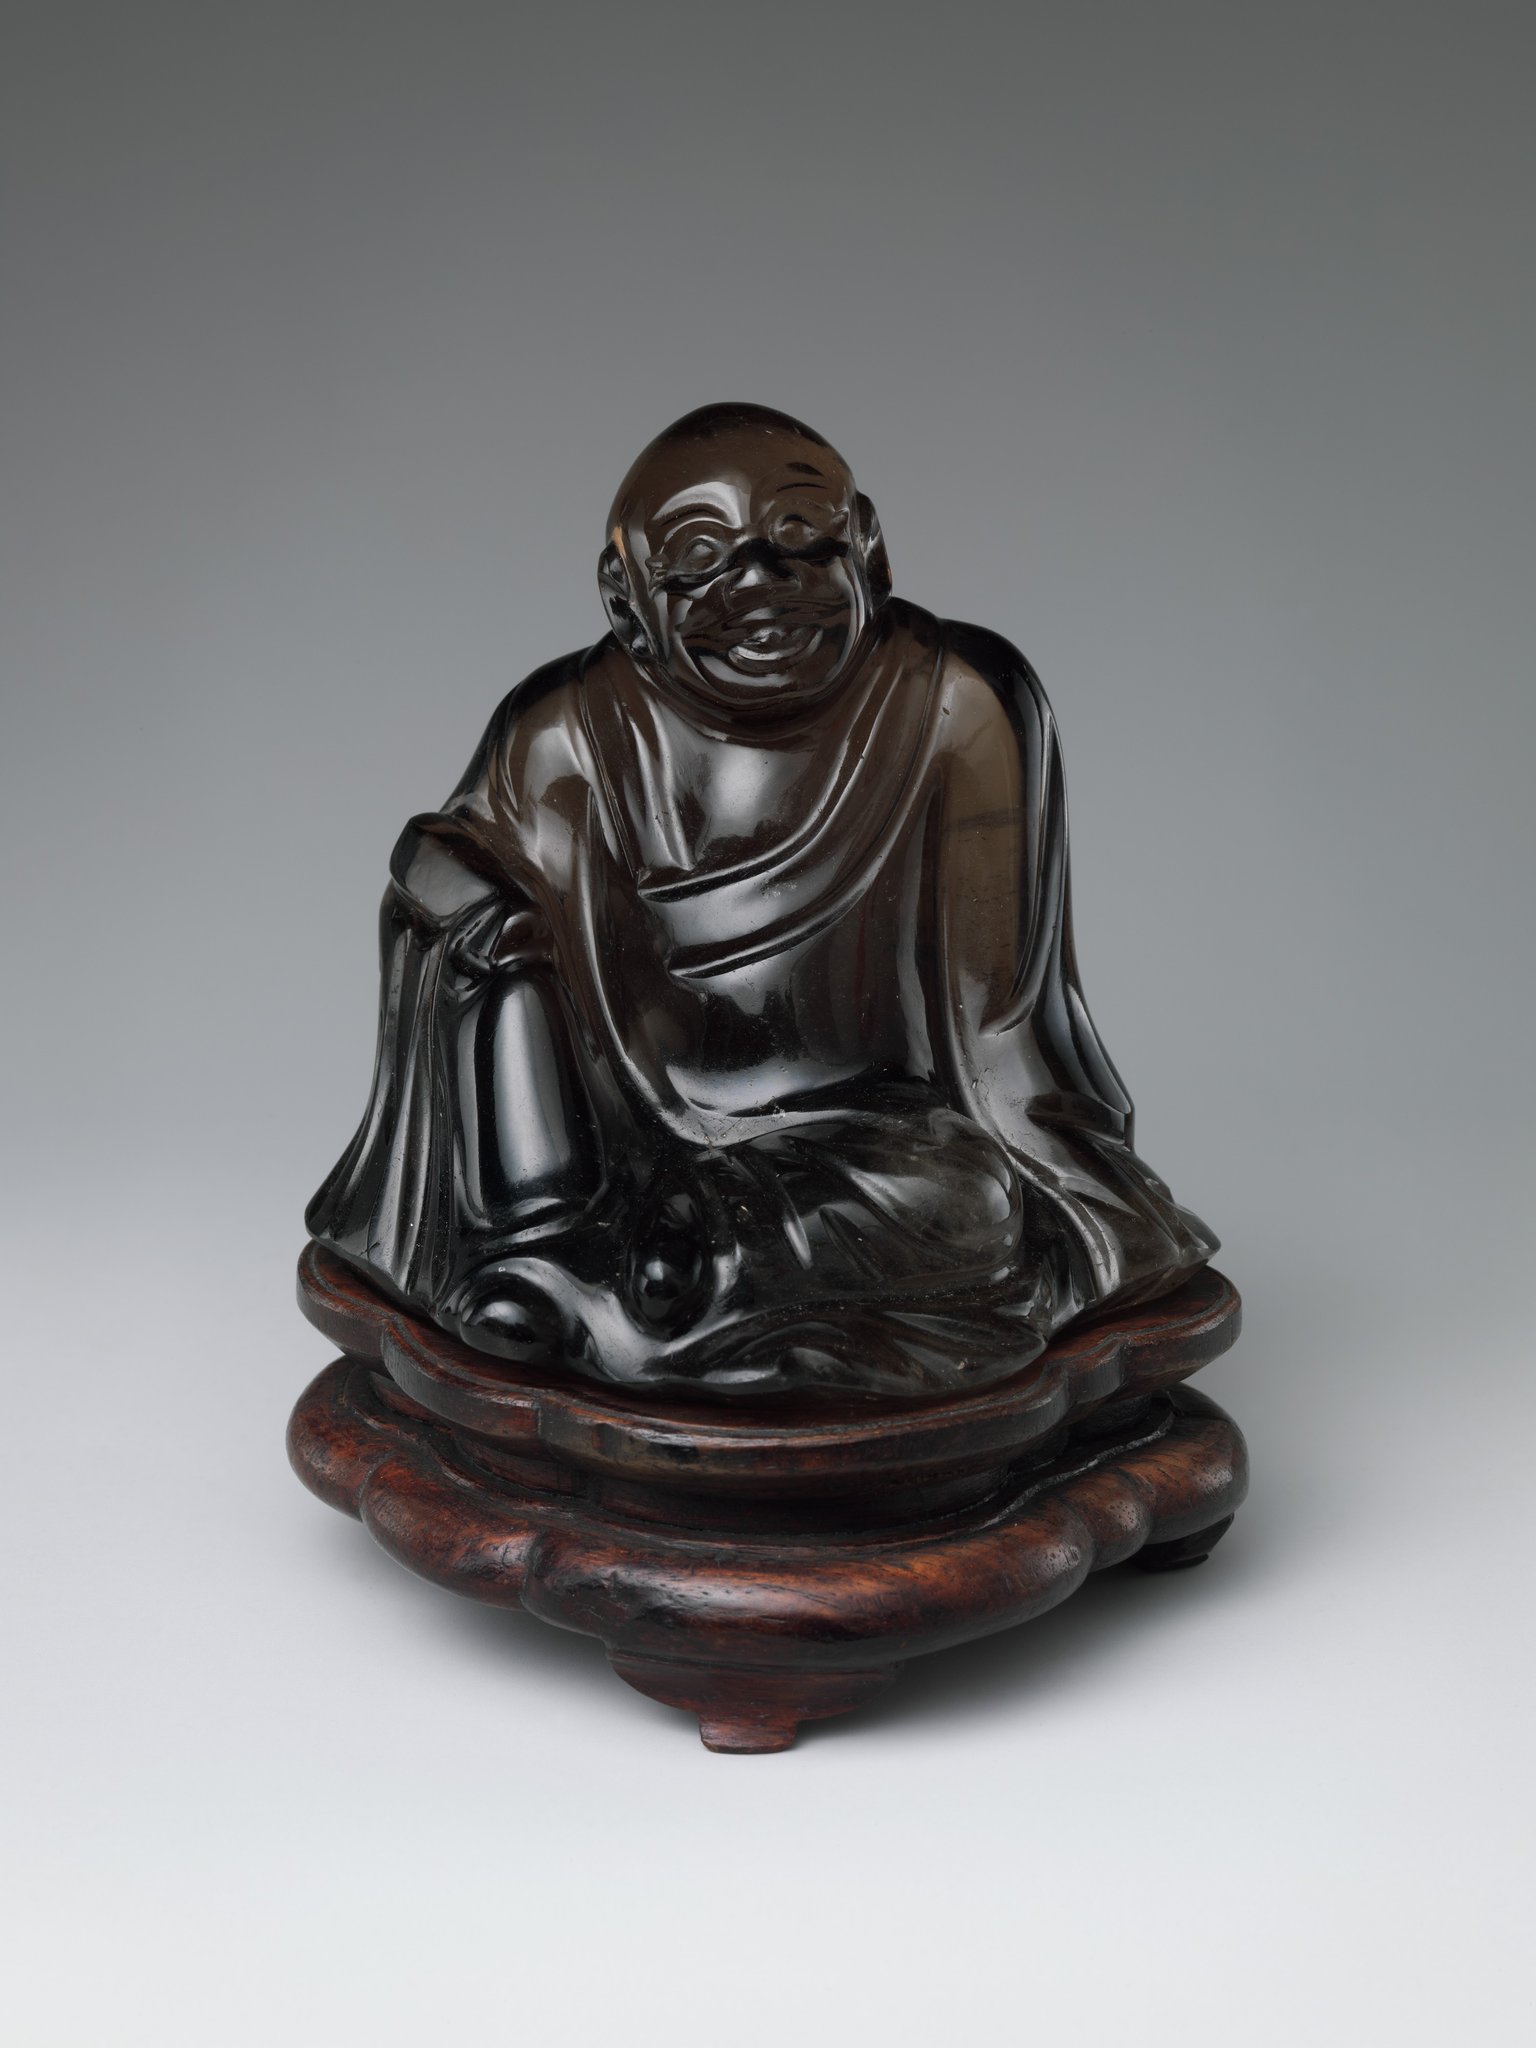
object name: figure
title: Seated Buddha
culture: chinese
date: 1701-1900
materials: quartz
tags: buddha